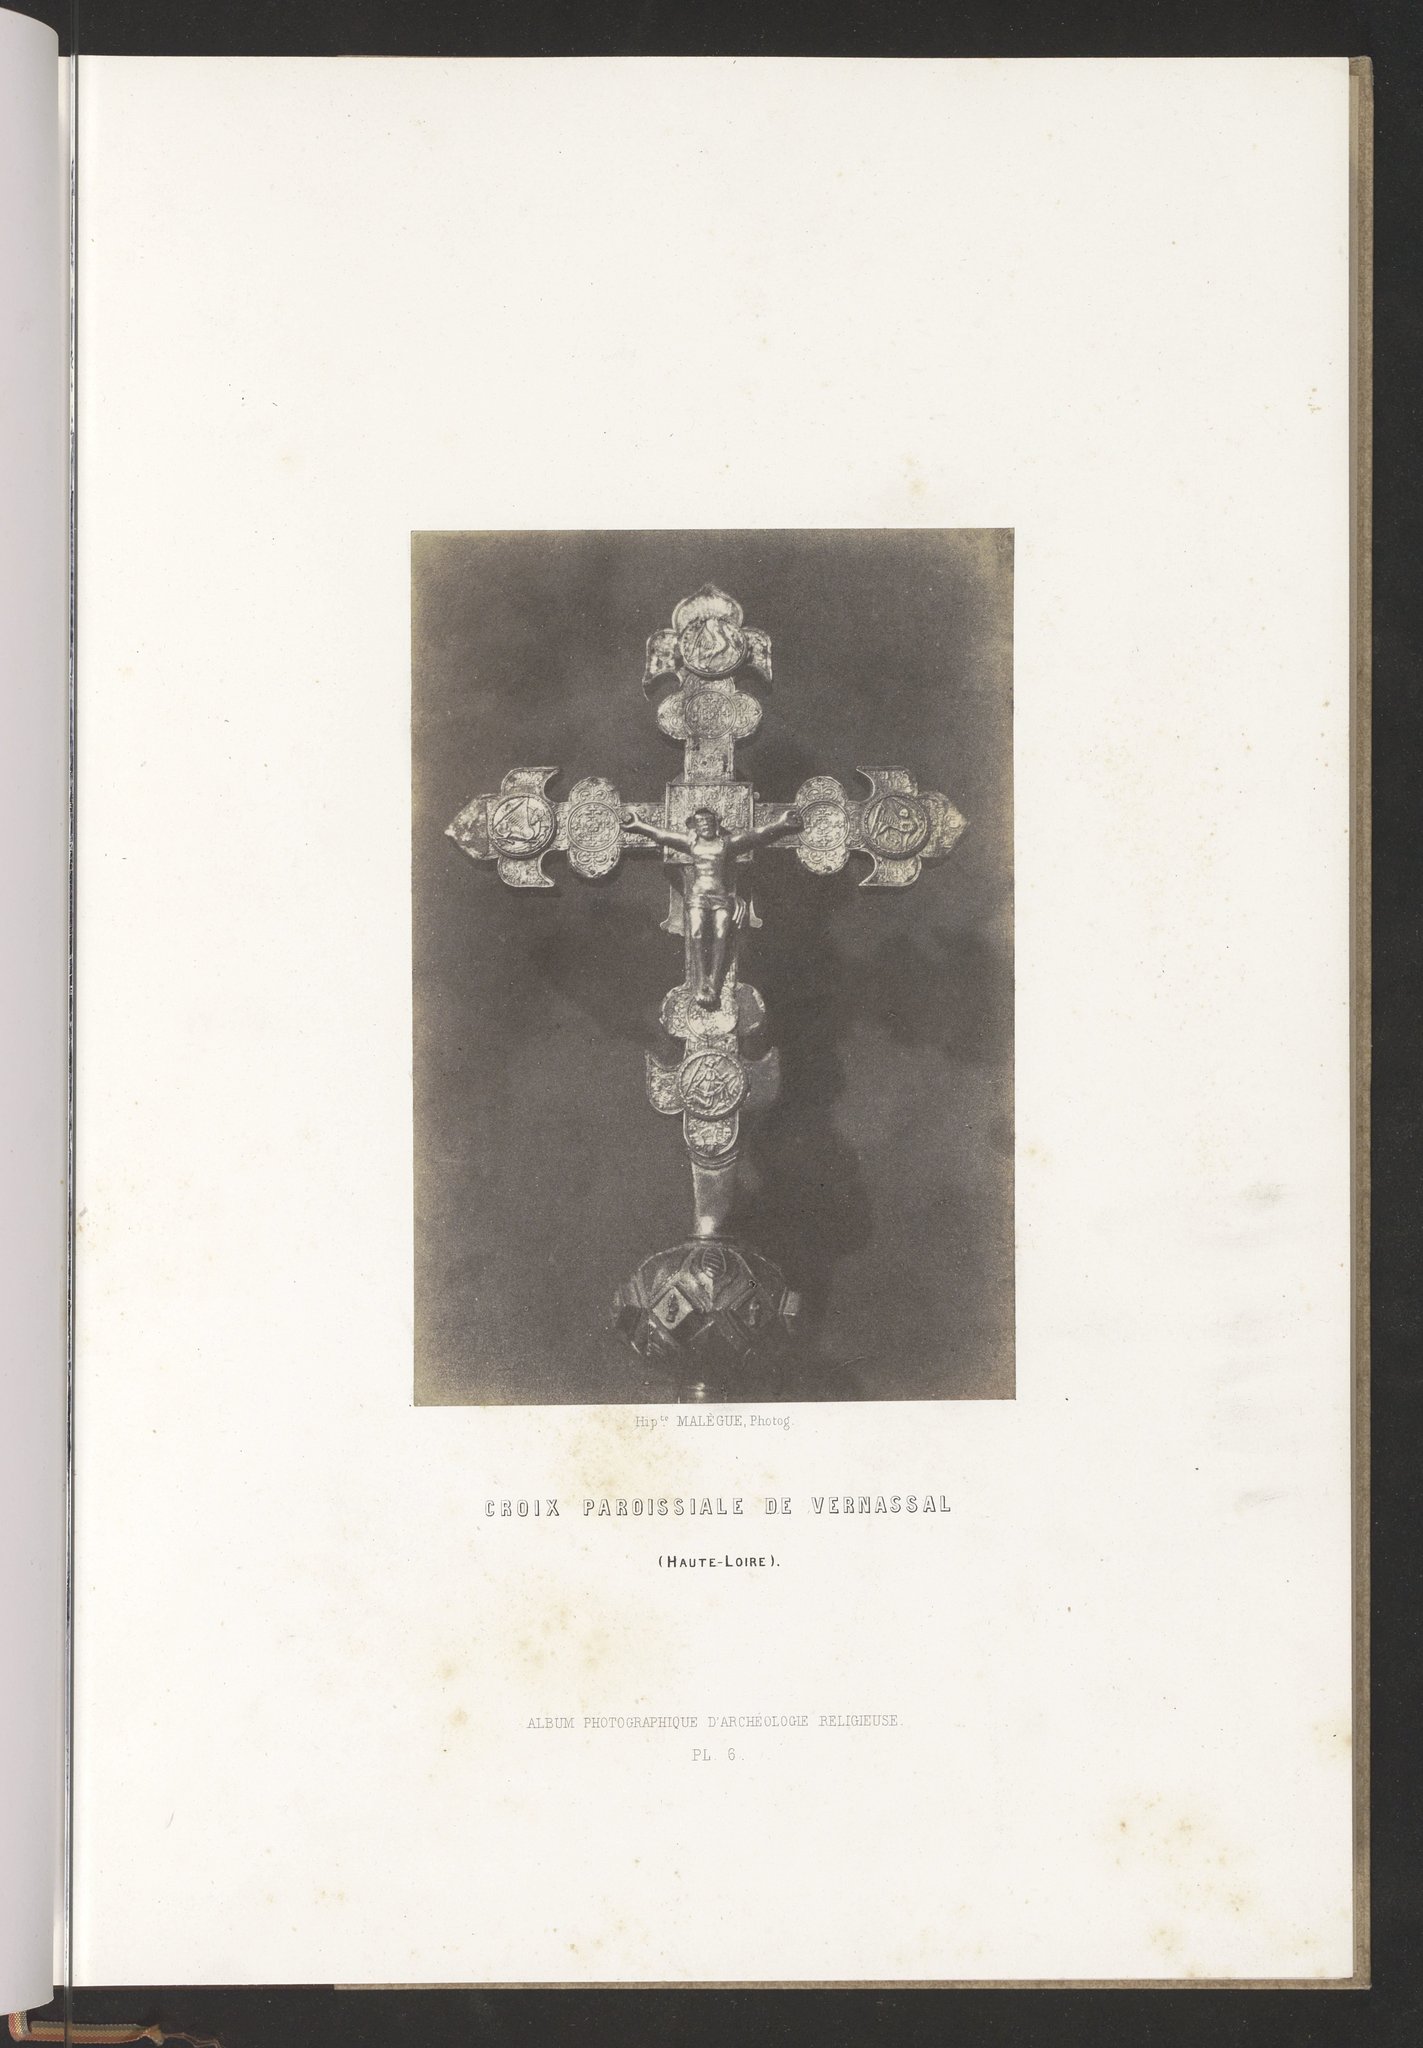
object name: photograph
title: Croix paroissiale de Vernassal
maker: hippolyte malègue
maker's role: archeoloog, fotograaf, schrijver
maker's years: 1825-1901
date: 1850-1857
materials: photographic support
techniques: salted paper print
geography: france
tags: crucifix ~ personal devotion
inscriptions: number: ‘PL. 6.’, inscription: ‘(Haute-Loire).’